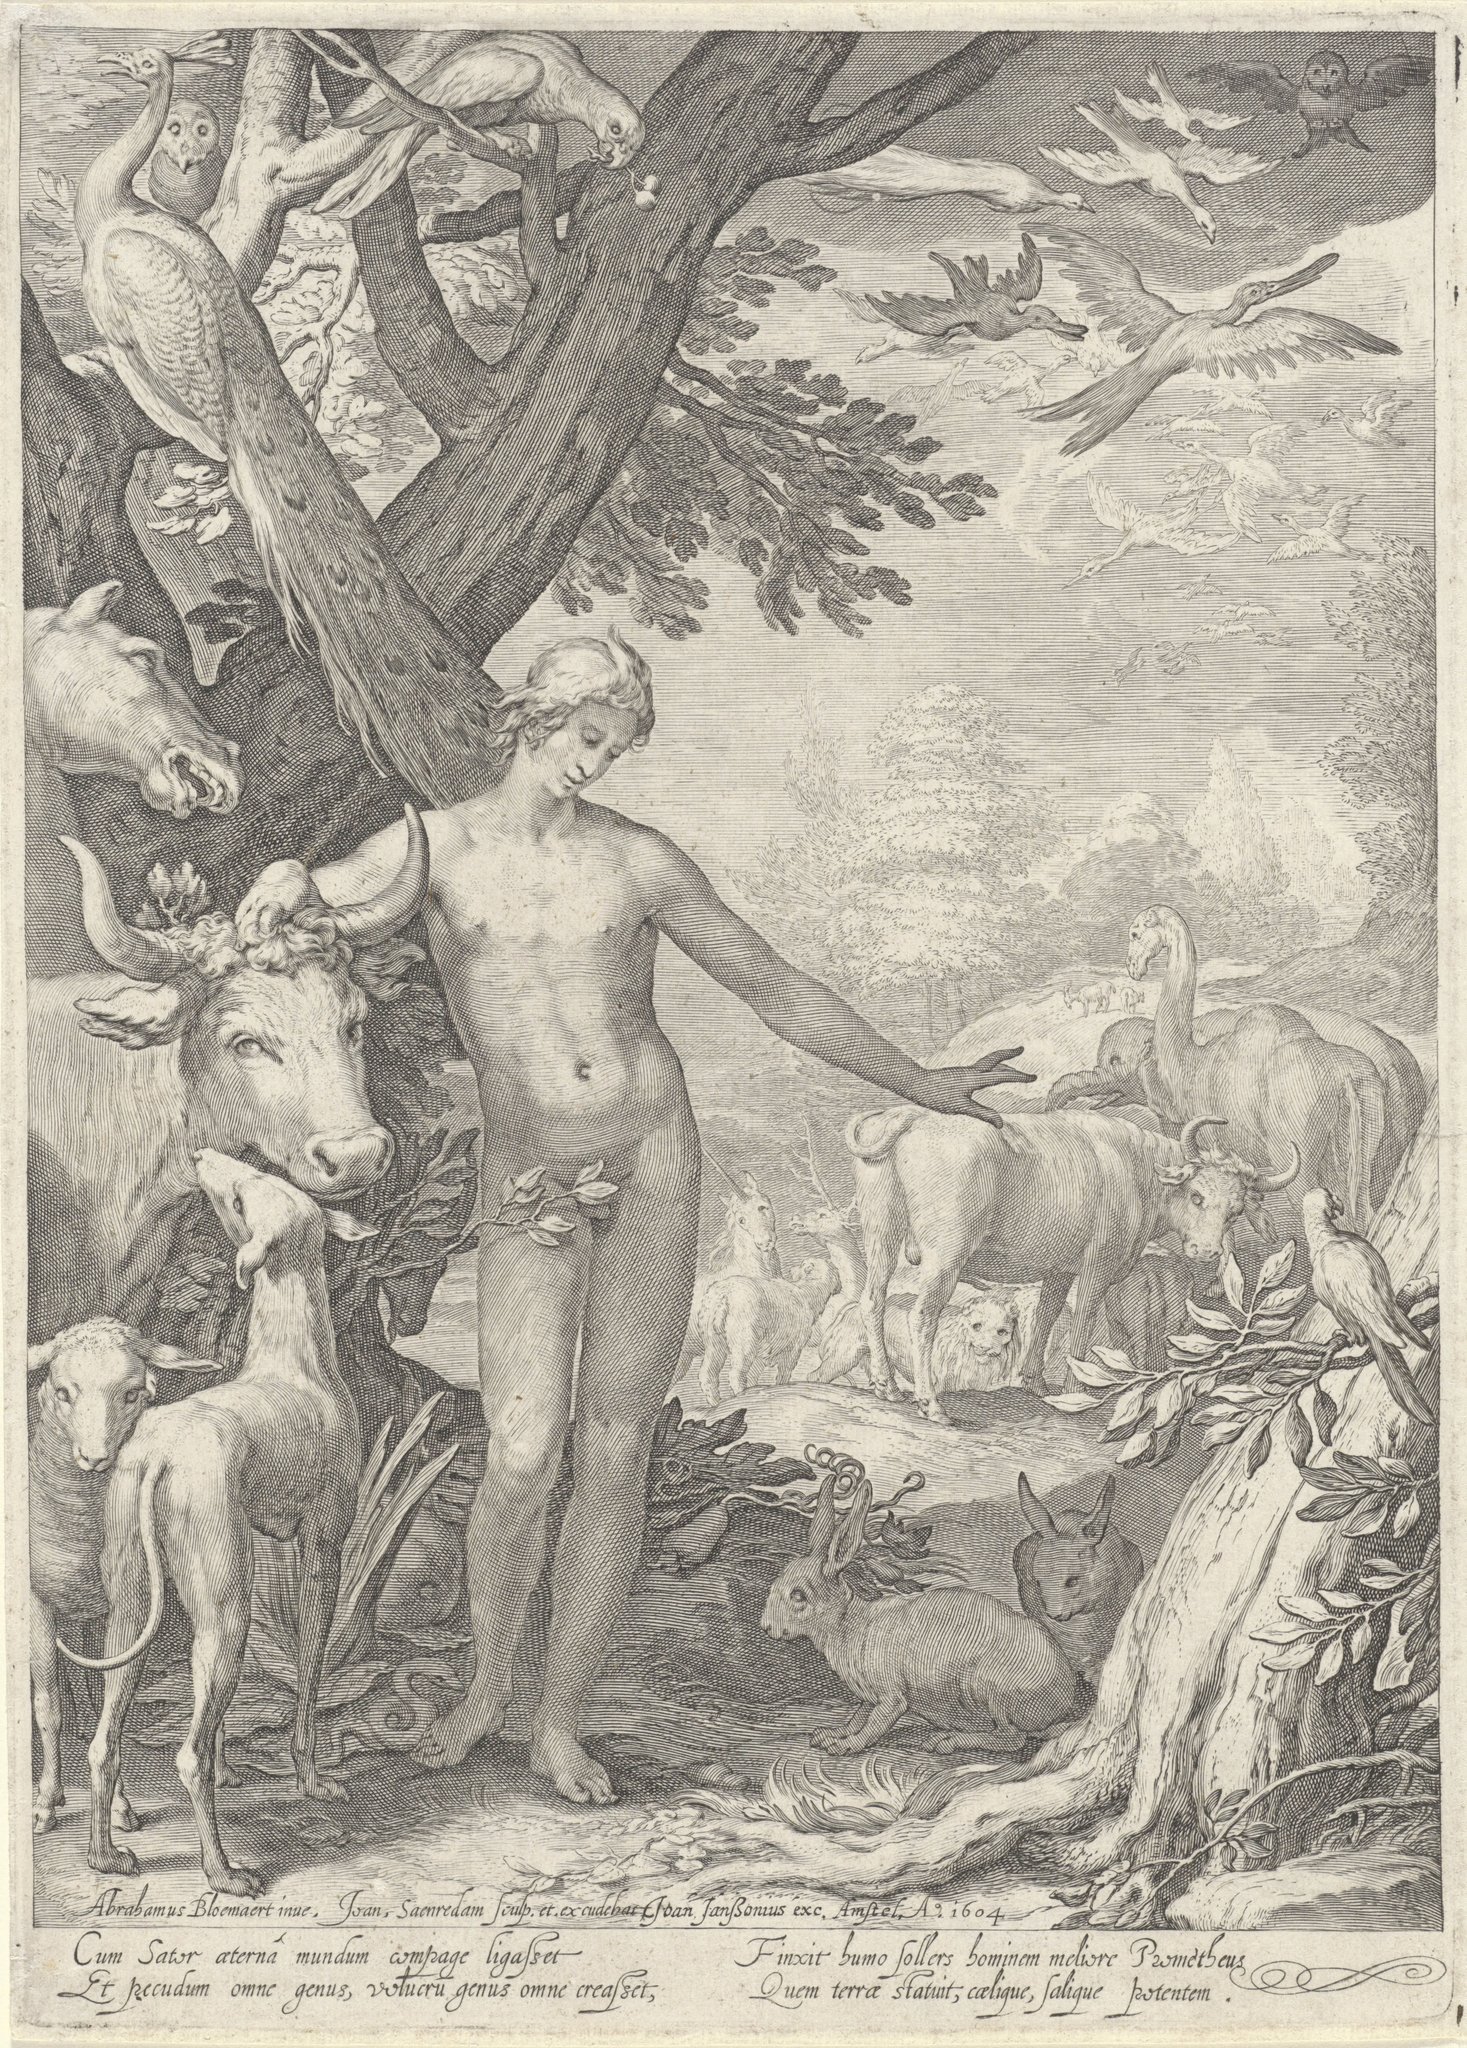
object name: print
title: Adam geeft de dieren namen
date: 1604-1665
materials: paper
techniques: engraving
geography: amsterdam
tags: adam naming the animals, unicorn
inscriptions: collector's mark: Lugt 11, collector's mark: Lugt 10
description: Adam staat op de voorgrond. Rondom hem allerlei dieren (stier, hond, schapp, slang, haas, paus, papegaai). Op de achtergrond andere dieren (olifant, leeuw, eenhoorn, kameel) en in de lucht vogels. Adam geeft elk van de dieren een naam. De eerste prent van een zesdelige reeks met als onderwerp het verhaal van Adam en Eva.